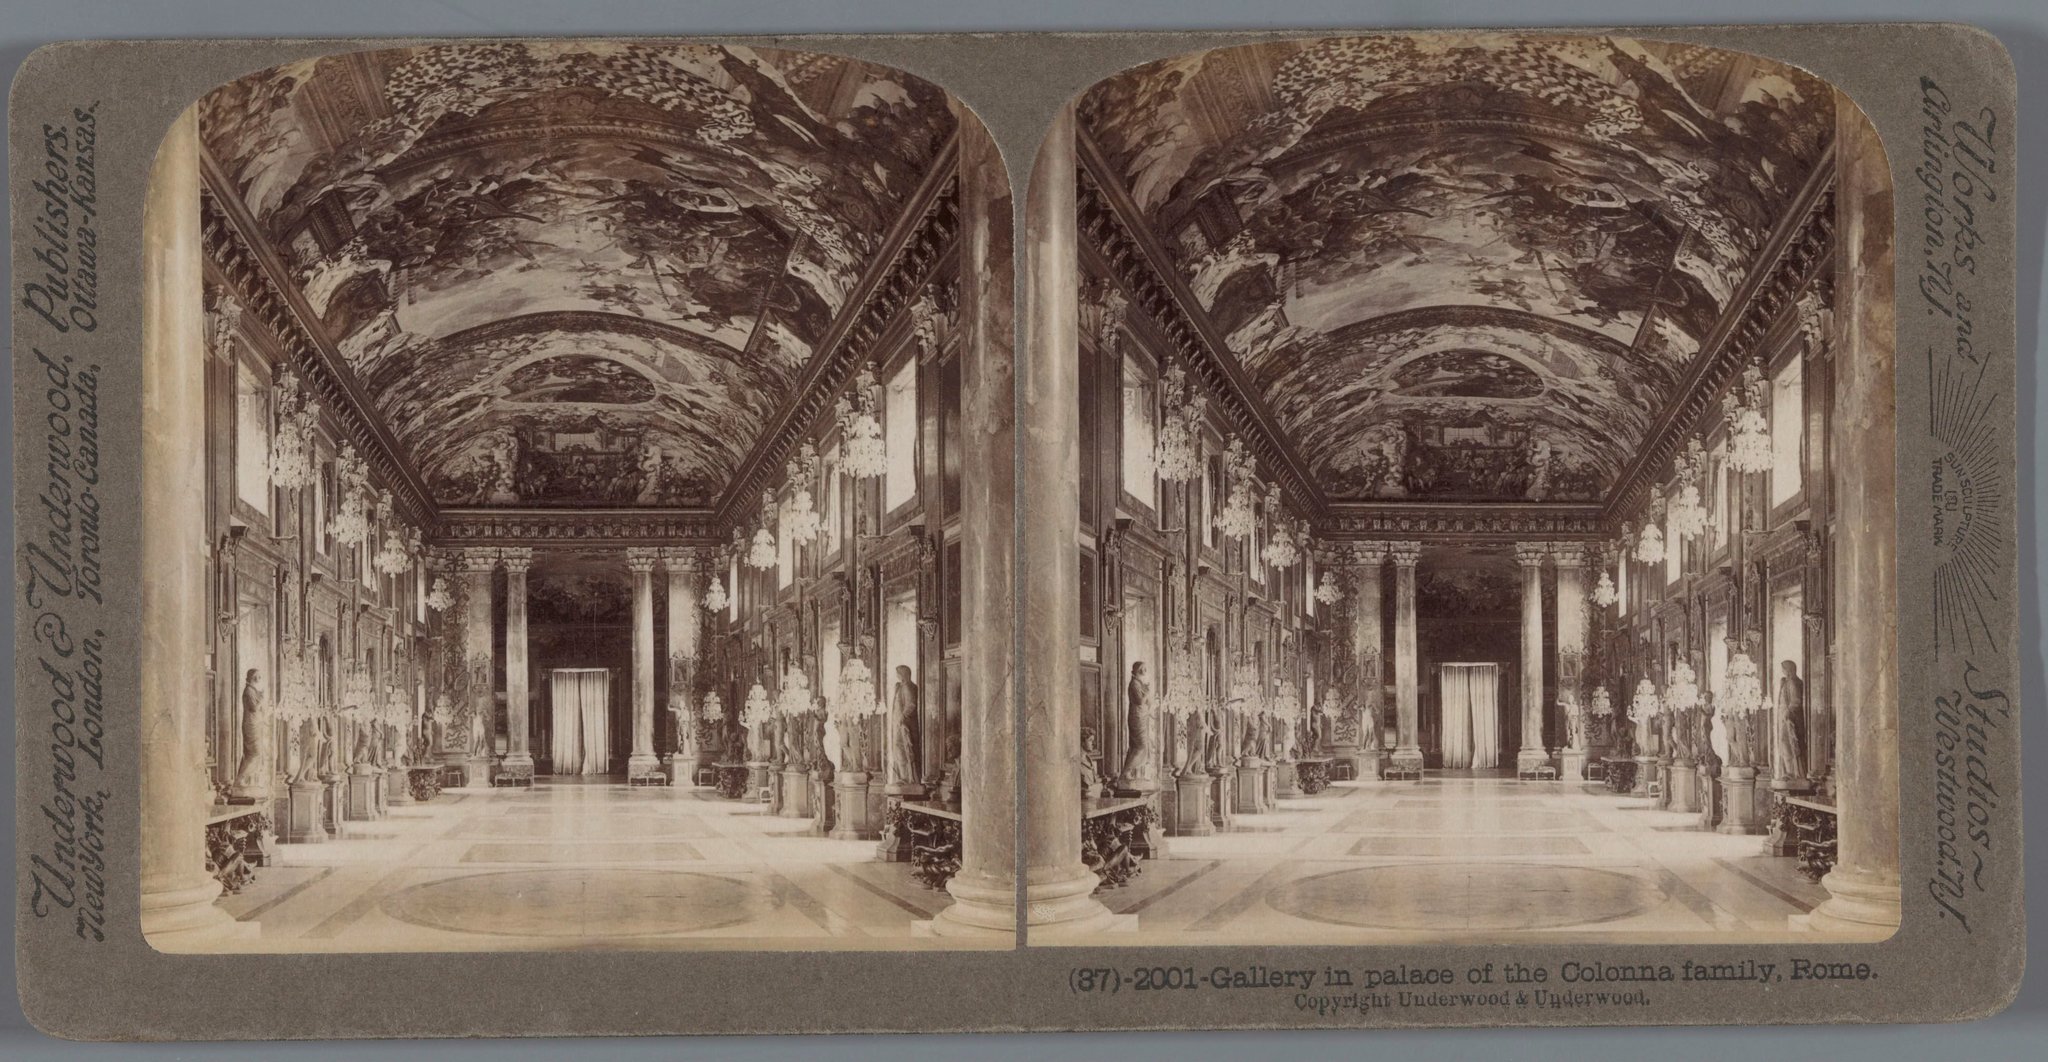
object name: stereograph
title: Gallery in palace of the Colonna family, Rome.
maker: Anonymous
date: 1890-1910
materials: cardboard, photographic support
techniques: albumen print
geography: palazzo colonna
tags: sculpture, (decorated) ceiling, interior ~ representation of a building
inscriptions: inscription: ‘Works and Studios Arlington, N.J. Westwood, N.J. Washington, D.C.’, name: ‘Underwood & Underwood Publishers New York, London, Toronto-Canada, Ottawa-Kansas.’, number: ‘(87)-2001’